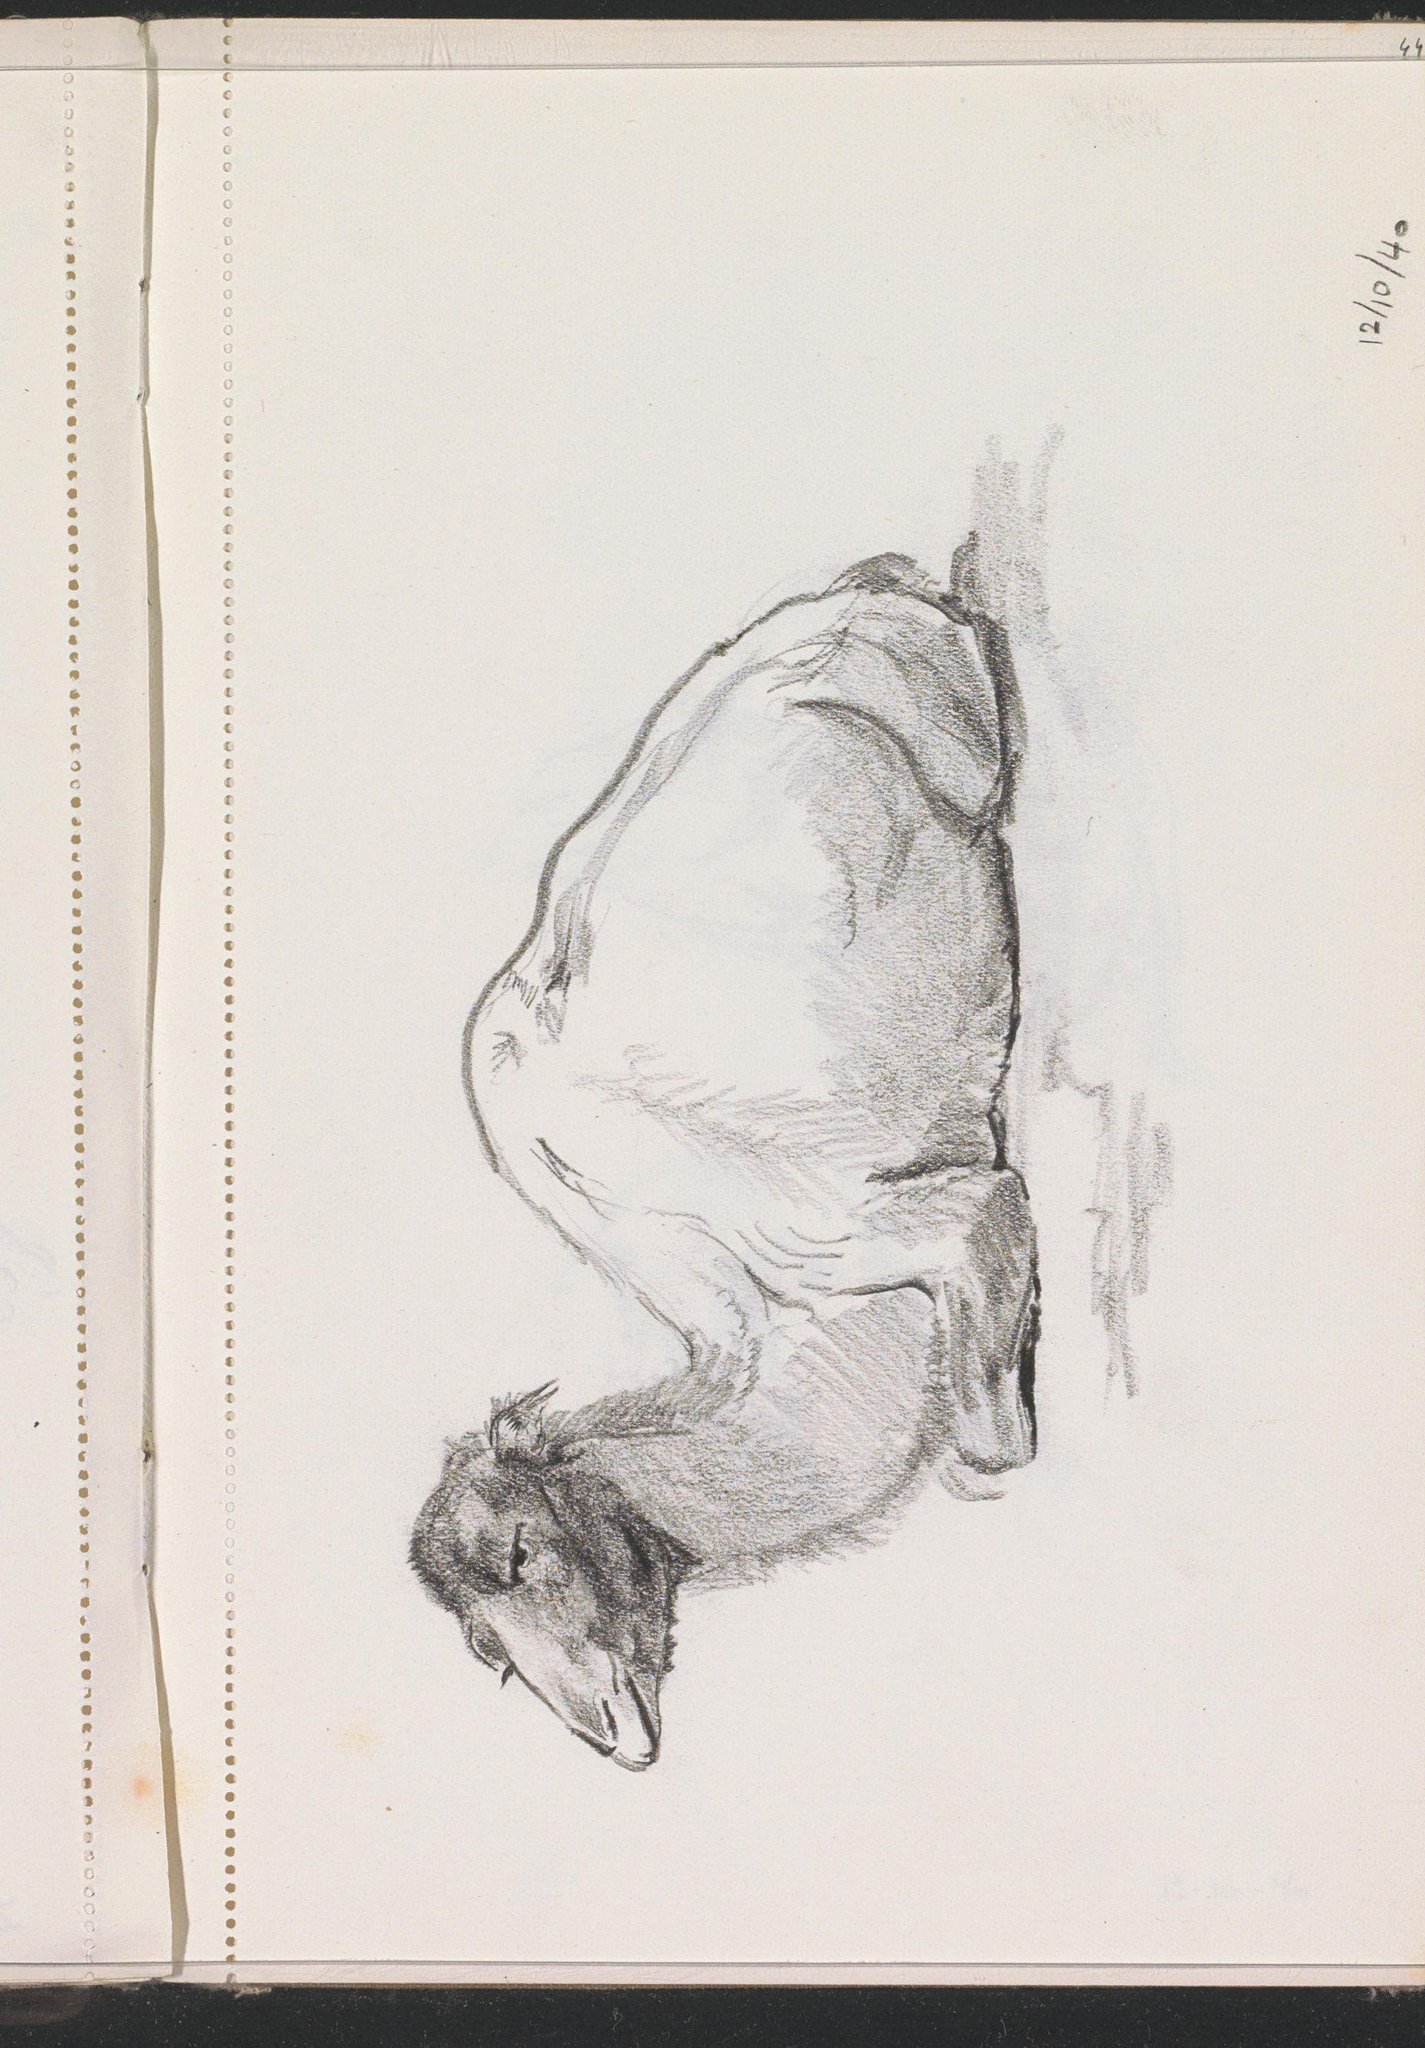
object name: sketchbook leaf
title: Liggende dromedaris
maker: otto verhagen (i)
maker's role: draughtsman, print maker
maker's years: 1885-1951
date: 1910-1940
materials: chalk, paper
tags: hoofed animals: dromedary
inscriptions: date: ‘12/10/40’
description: Pagina 44 uit een schetsboek met 60 bladen.